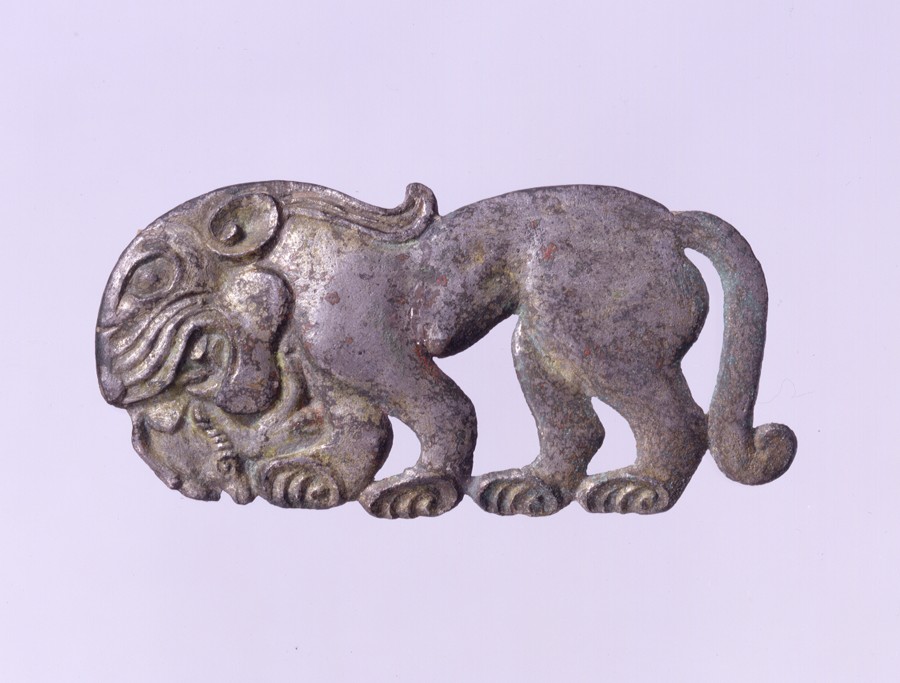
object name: belt plaque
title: Belt Plaque in the Shape of a Standing Feline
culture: chinese or mongolian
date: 400-301 BCE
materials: bronze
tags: lions